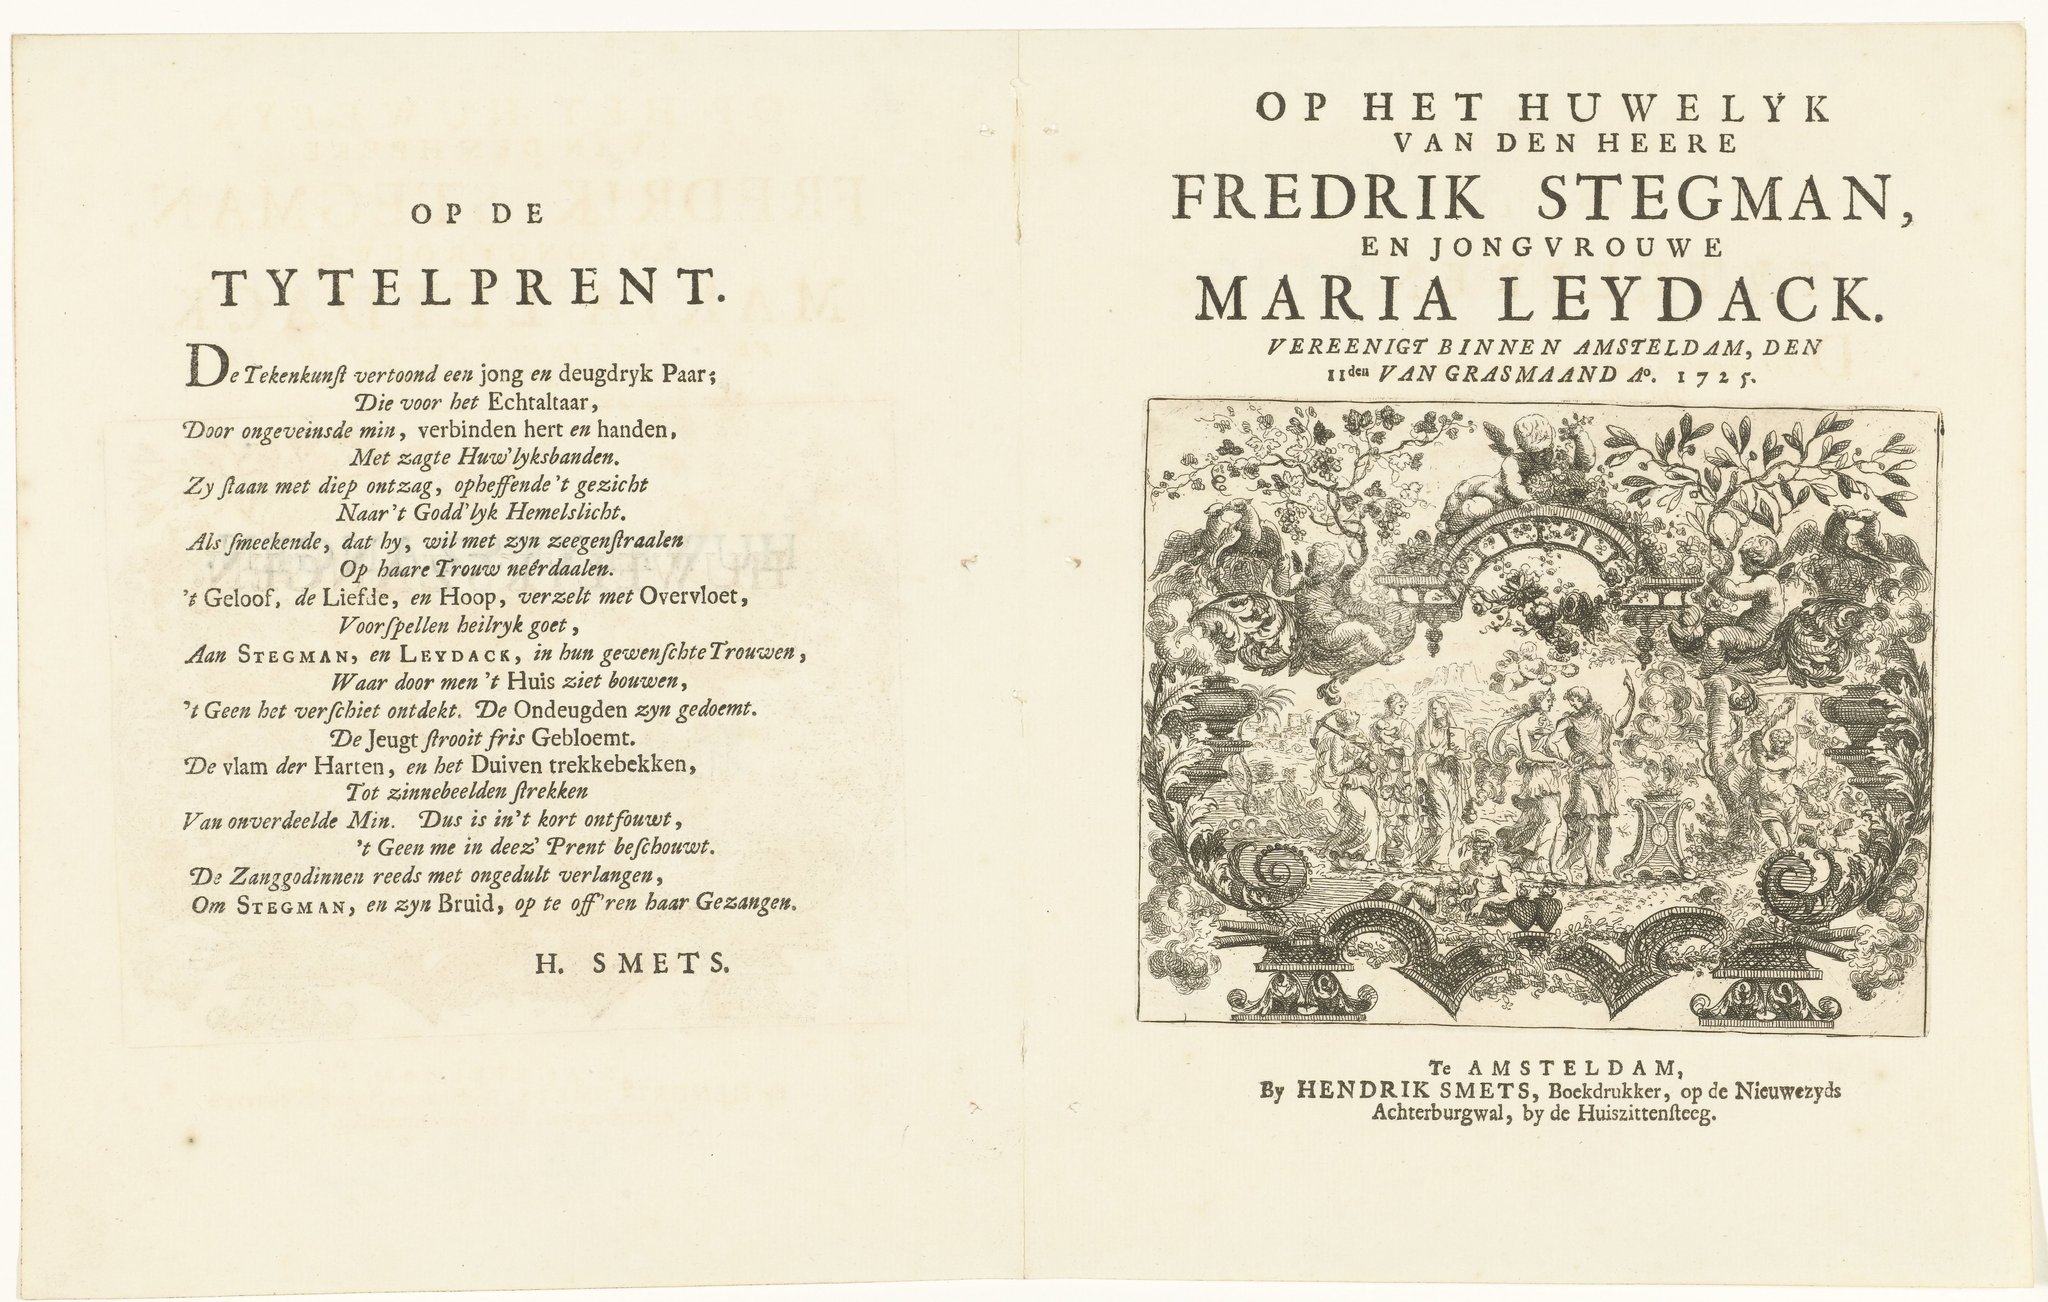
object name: titelblad, titelpagina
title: Bladzijde uit het huwelijksdicht voor Fredrik Stegman en Maria Leydack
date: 1725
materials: paper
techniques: etching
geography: amsterdam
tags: the three theological virtues, wedding feast, wedding meal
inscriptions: collector's mark: Lugt 2760, collector's mark: Lugt 2228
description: Dubbelblad uit het huwelijksdicht voor Fredrik Stegman en Maria Leydack met een prent met een allegorie op het huwelijk. Een stel staat voor een reukaltaar. Naast hun Geloof, Hoop en Liefde. Het geheel is omlijst met bladranken, bomen, rook, putti en harten. Op de andere bladzijde een gedicht op de titelprent van H. Smets.